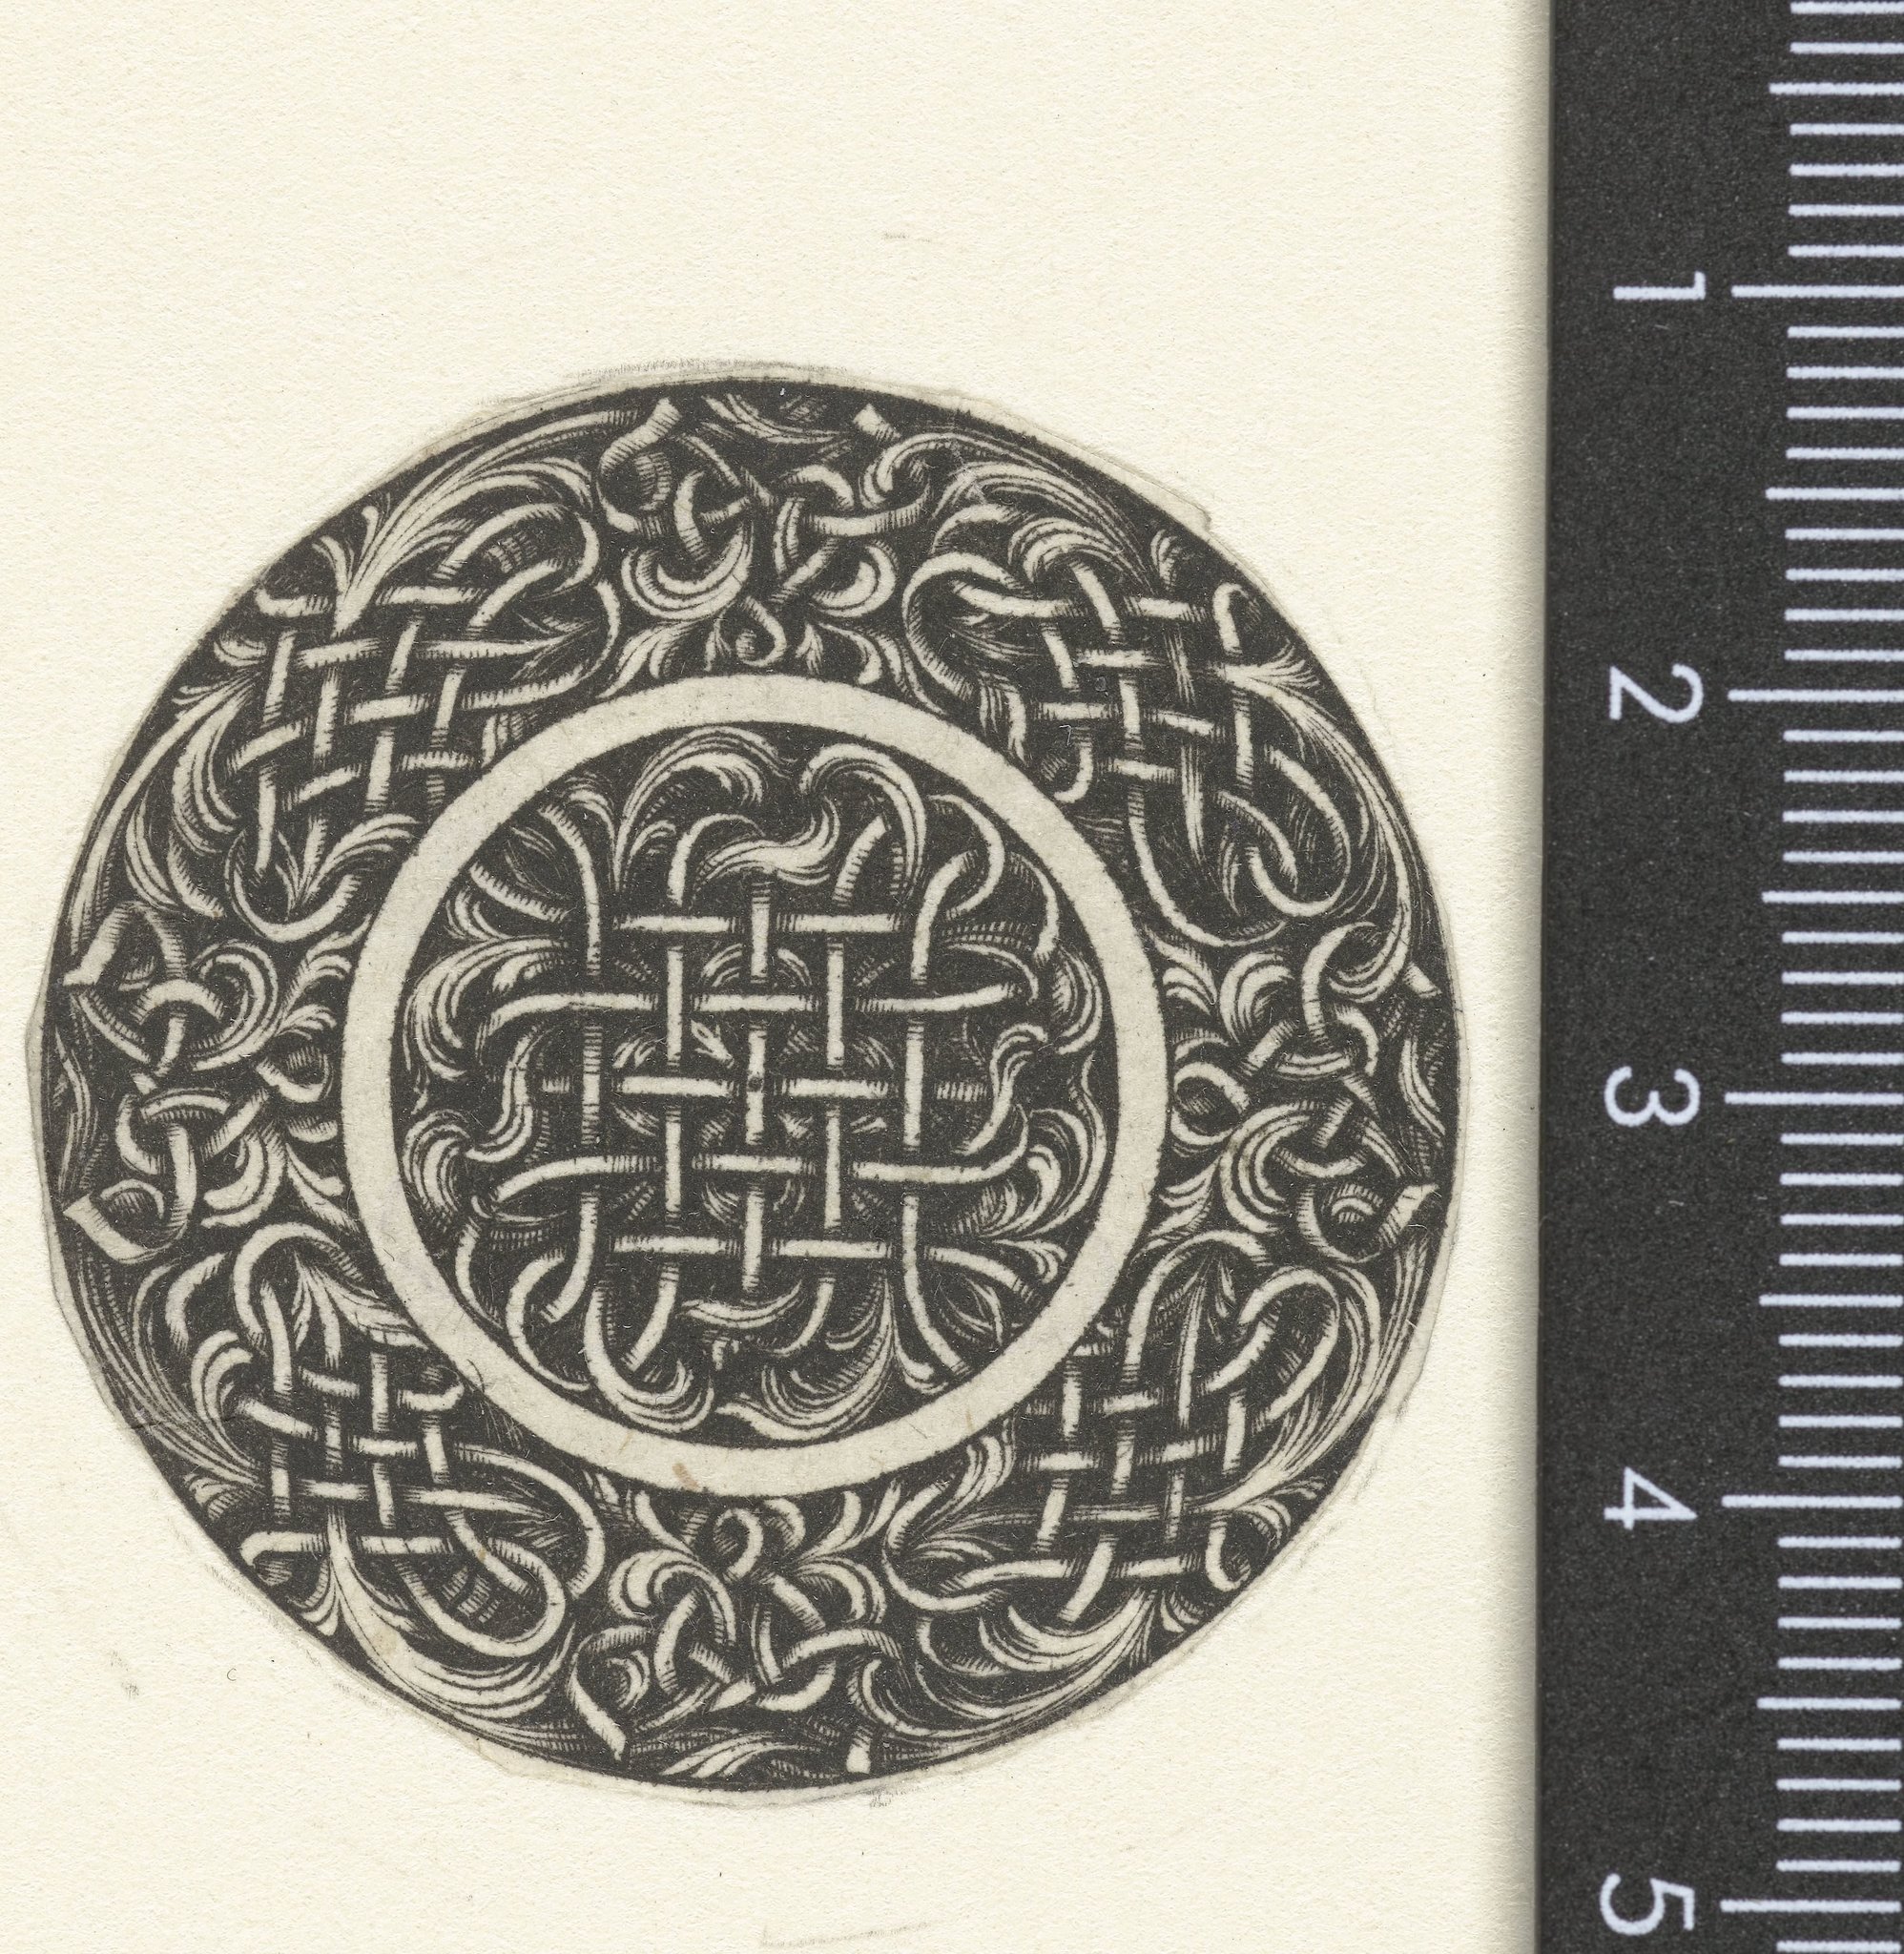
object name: print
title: Medaillon met vlechtwerk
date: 1631-1686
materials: paper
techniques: engraving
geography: france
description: Medaillon van blad 4 uit de serie Liures De Fleurs propres pour O'rfeures Et Graueurs.